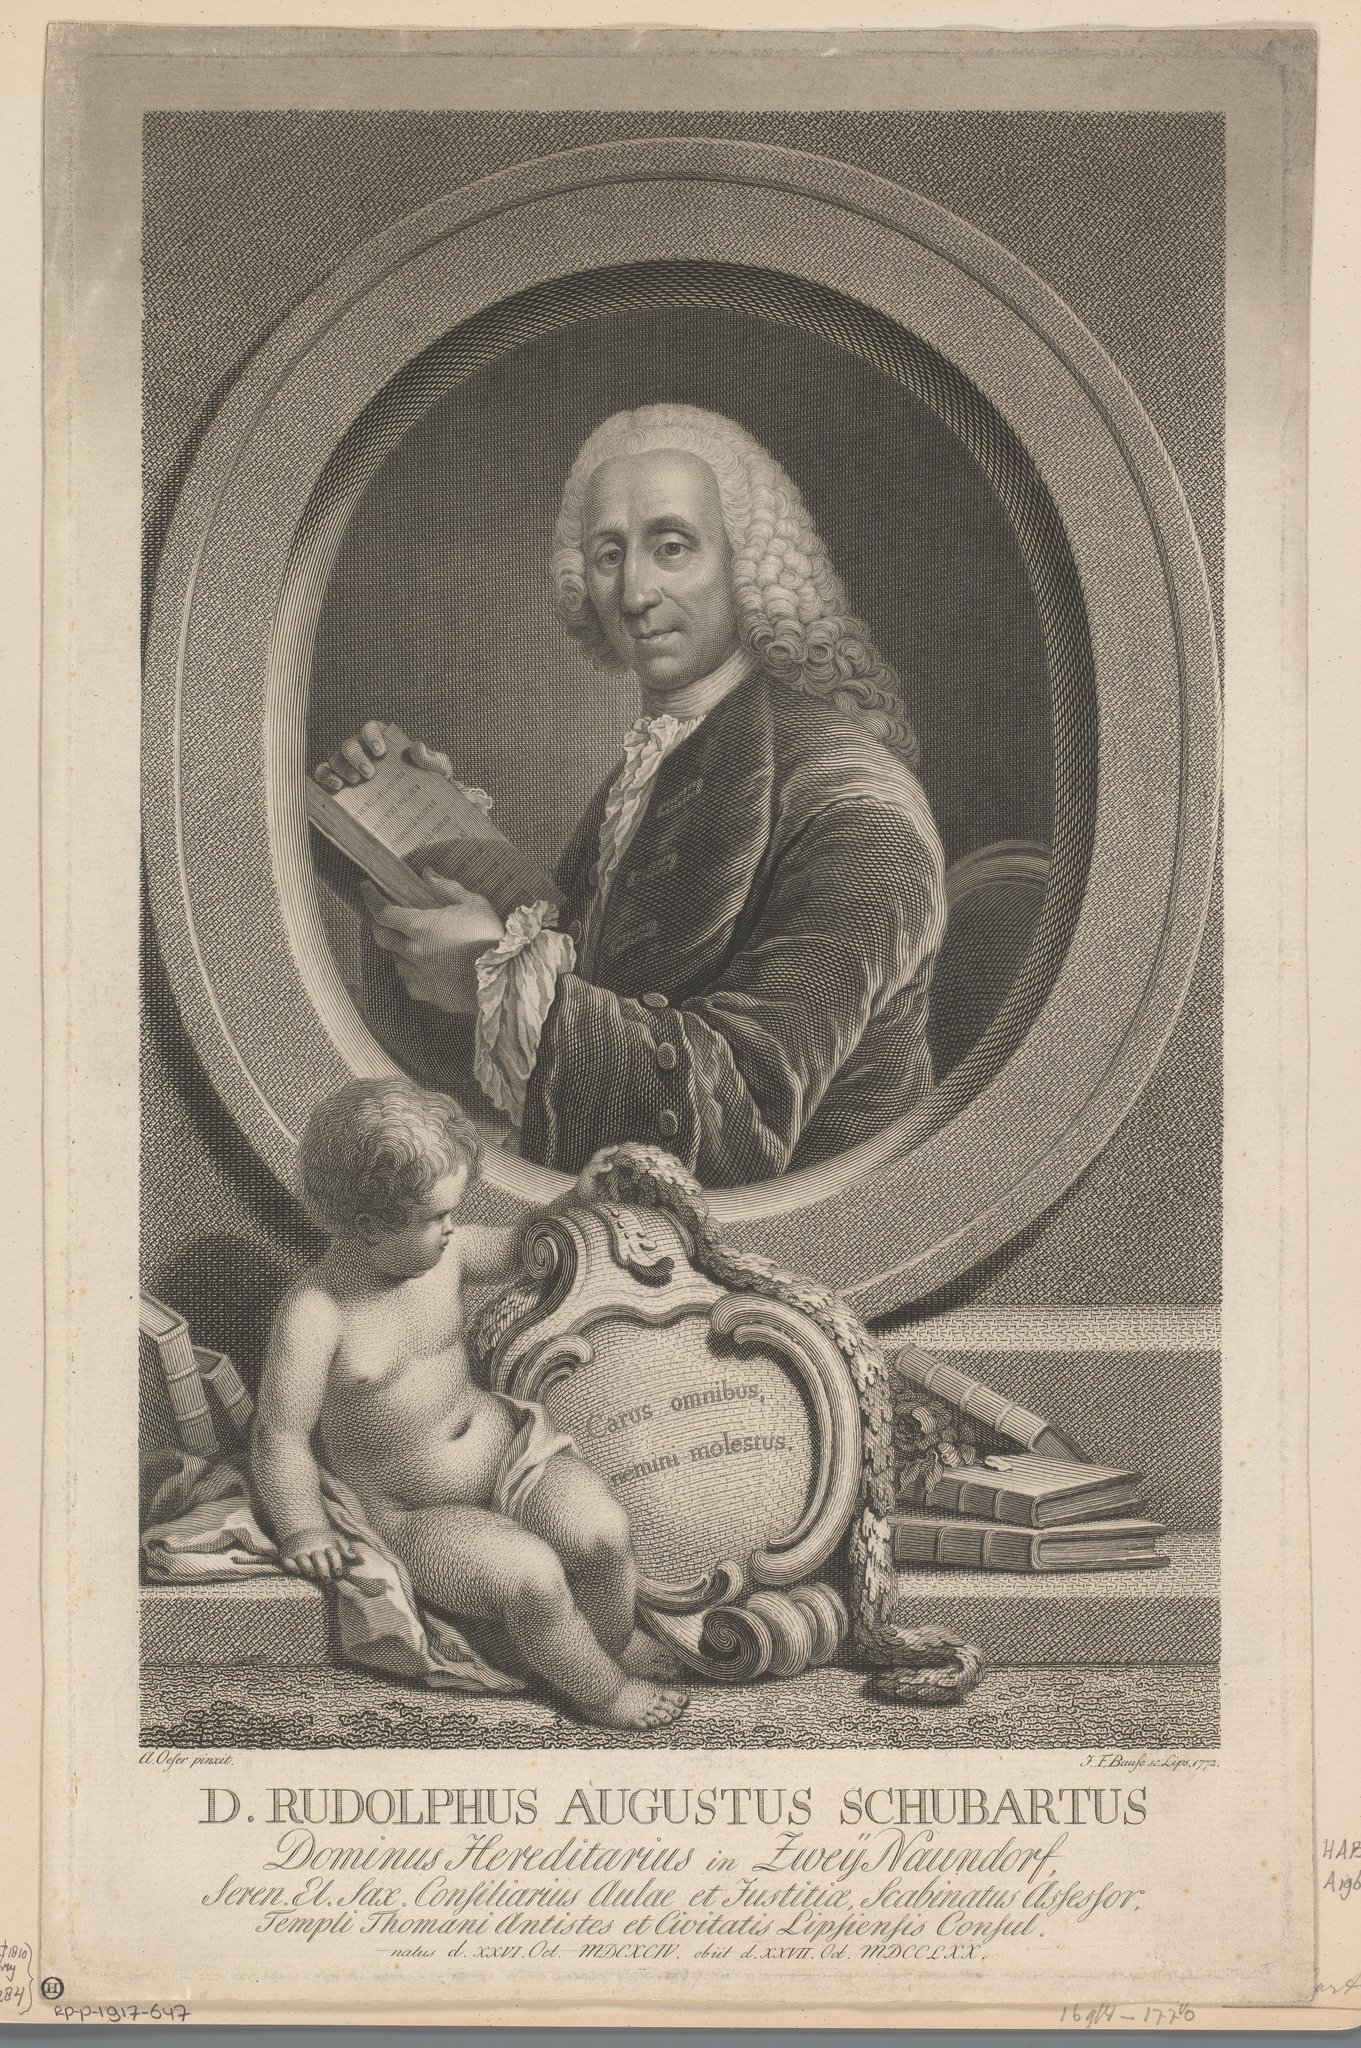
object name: print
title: Portret van Rudolf August Schubart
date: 1772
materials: paper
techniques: engraving, etching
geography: leipzig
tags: mayor, mayor, burgomaster, historical persons, lawyer, attorney at law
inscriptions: collector's mark: Lugt 1284, collector's mark: Lugt 2228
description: Met vijfregelig onderschrift in het Latijn.